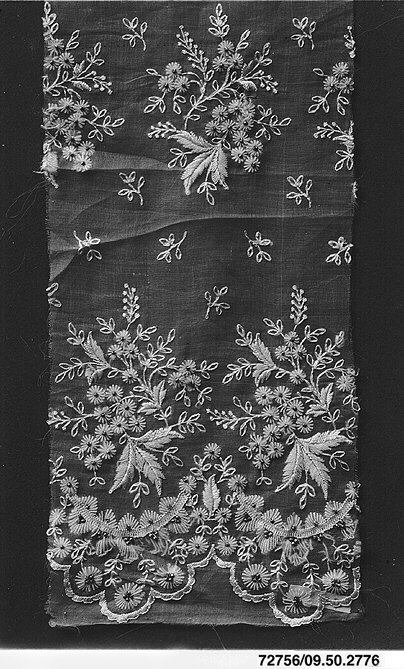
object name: fragment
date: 1801-1900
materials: silk, wool